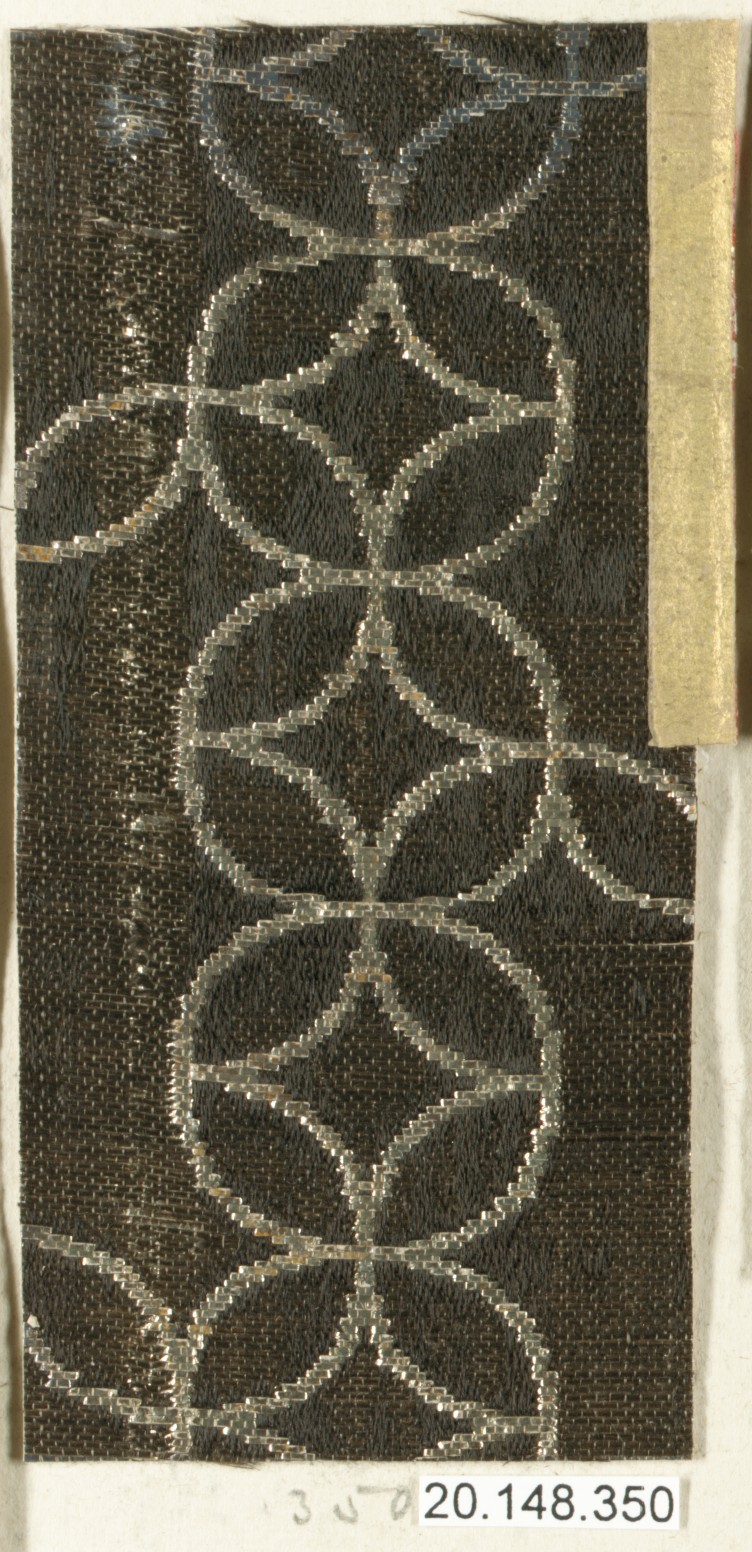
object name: piece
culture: japanese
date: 1701-1800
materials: silk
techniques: compound weave